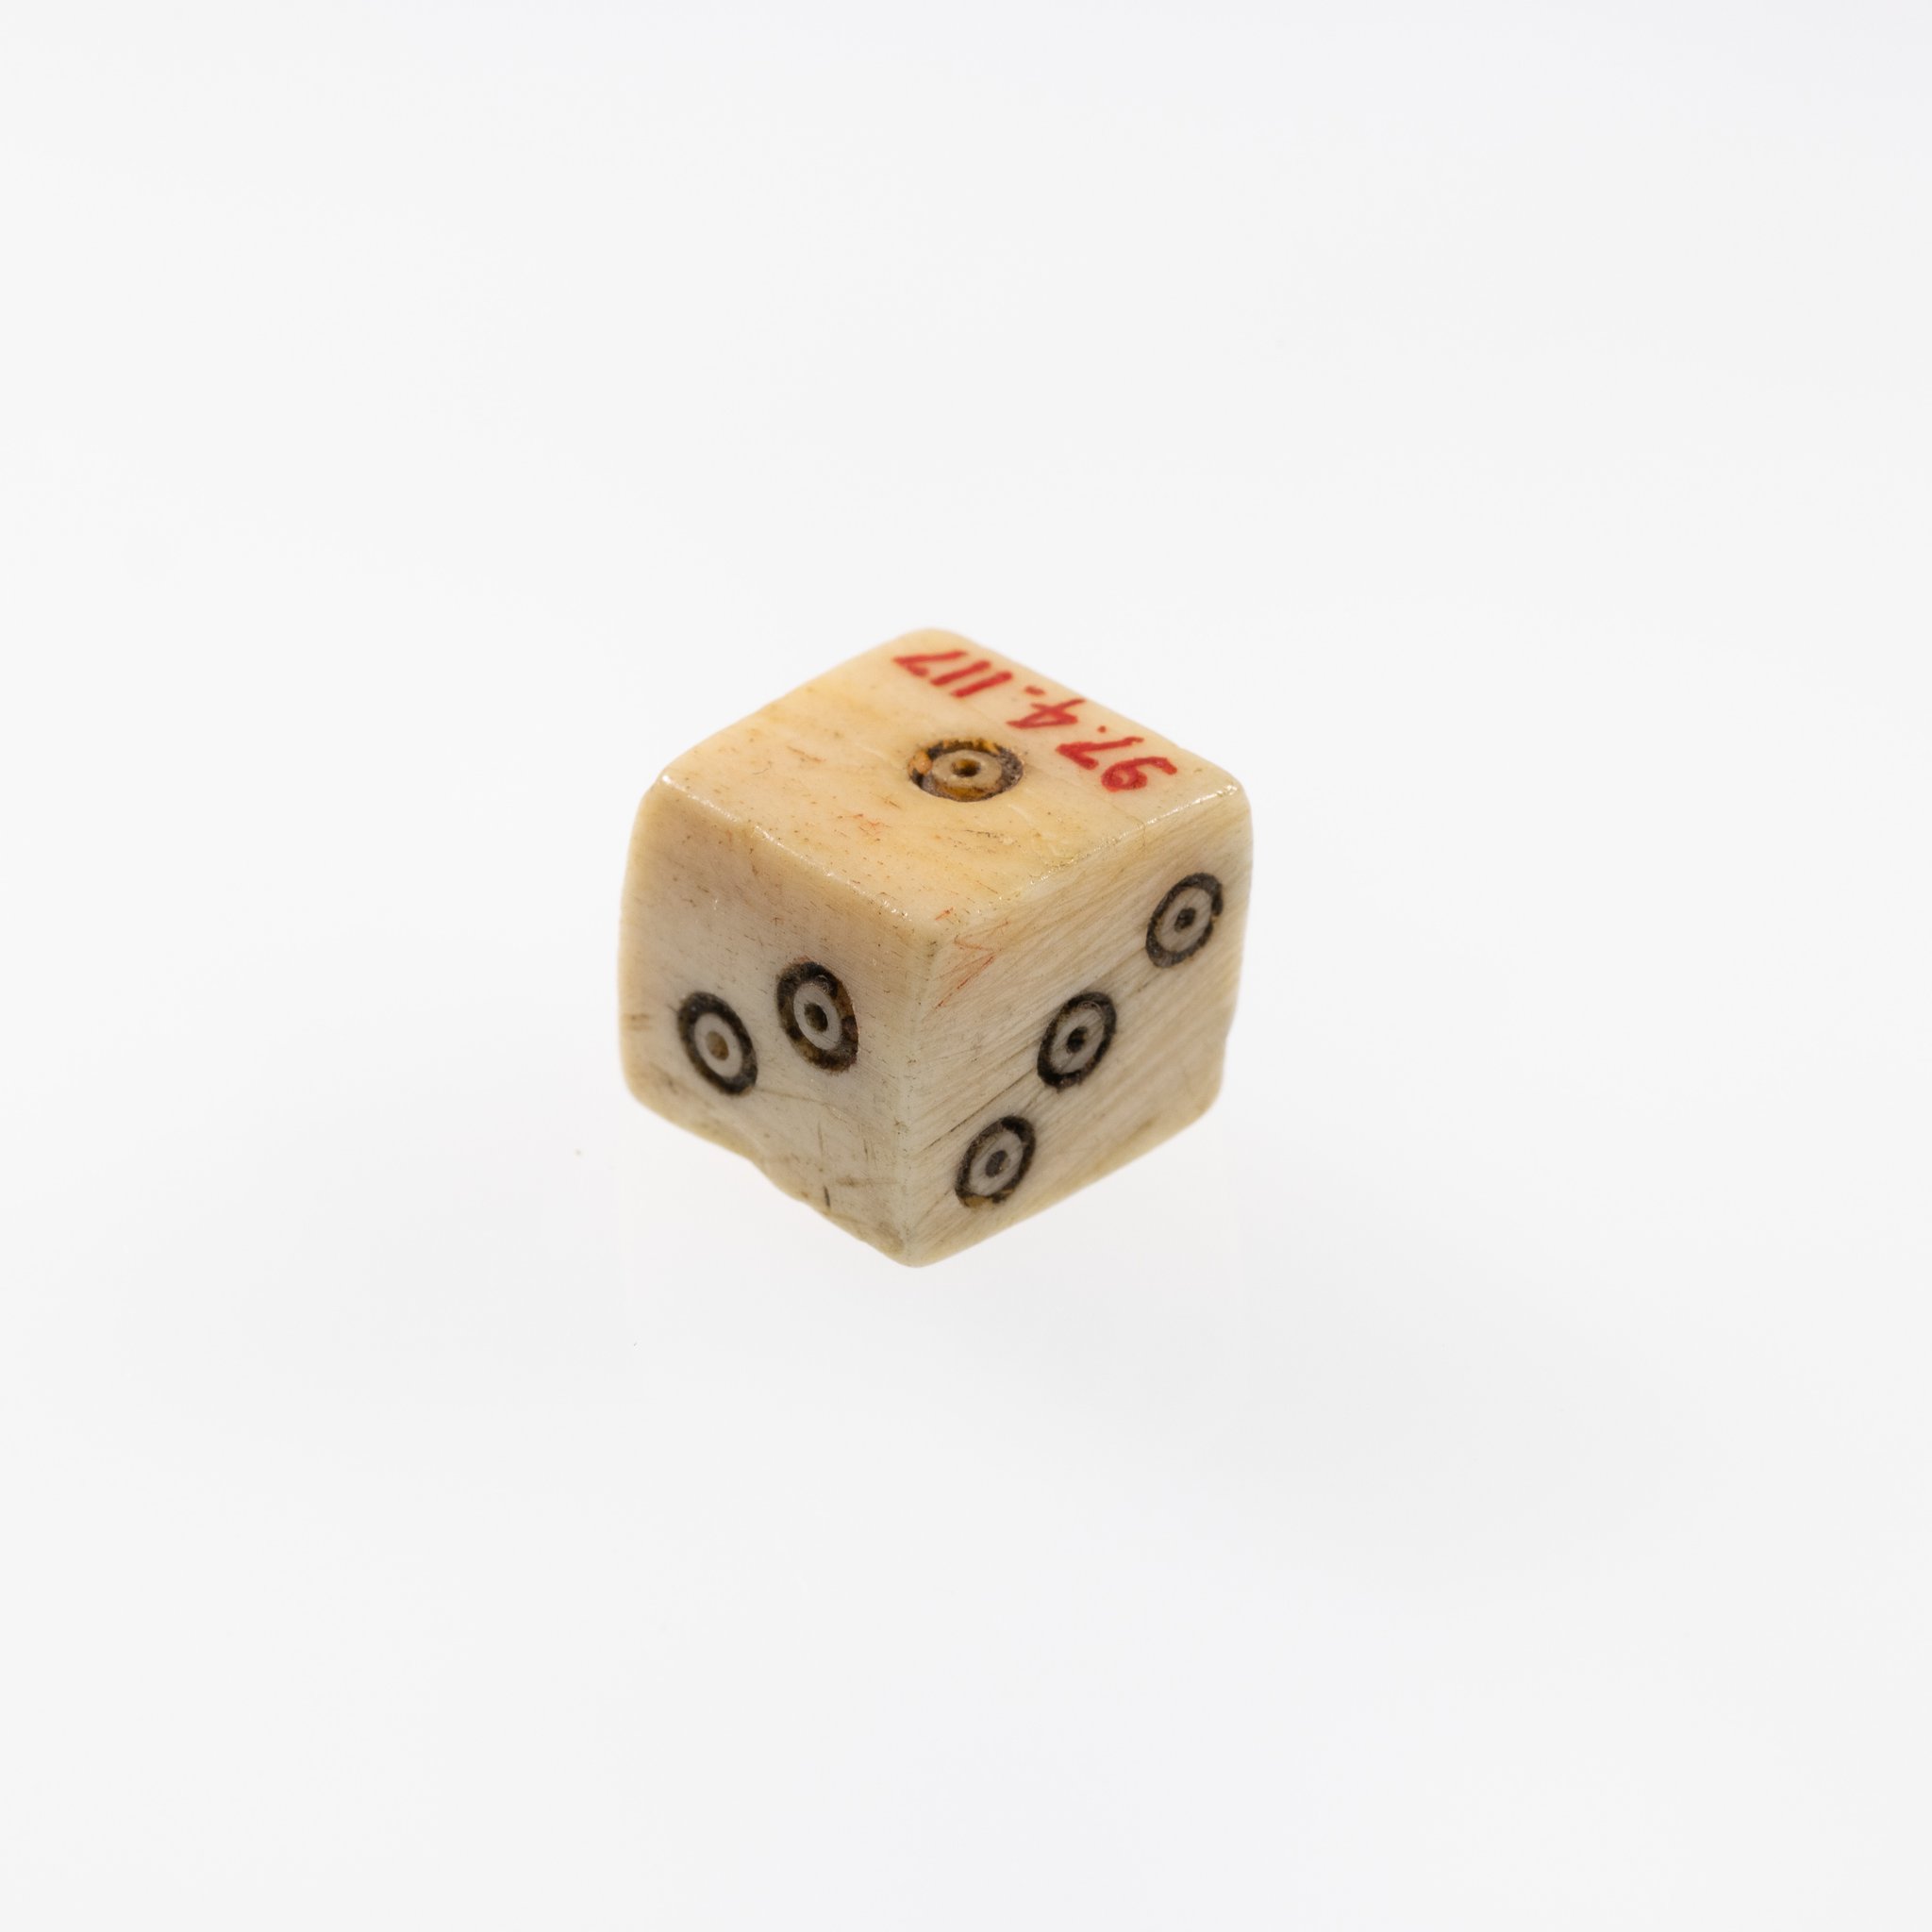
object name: dice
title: Die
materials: ivory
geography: egypt